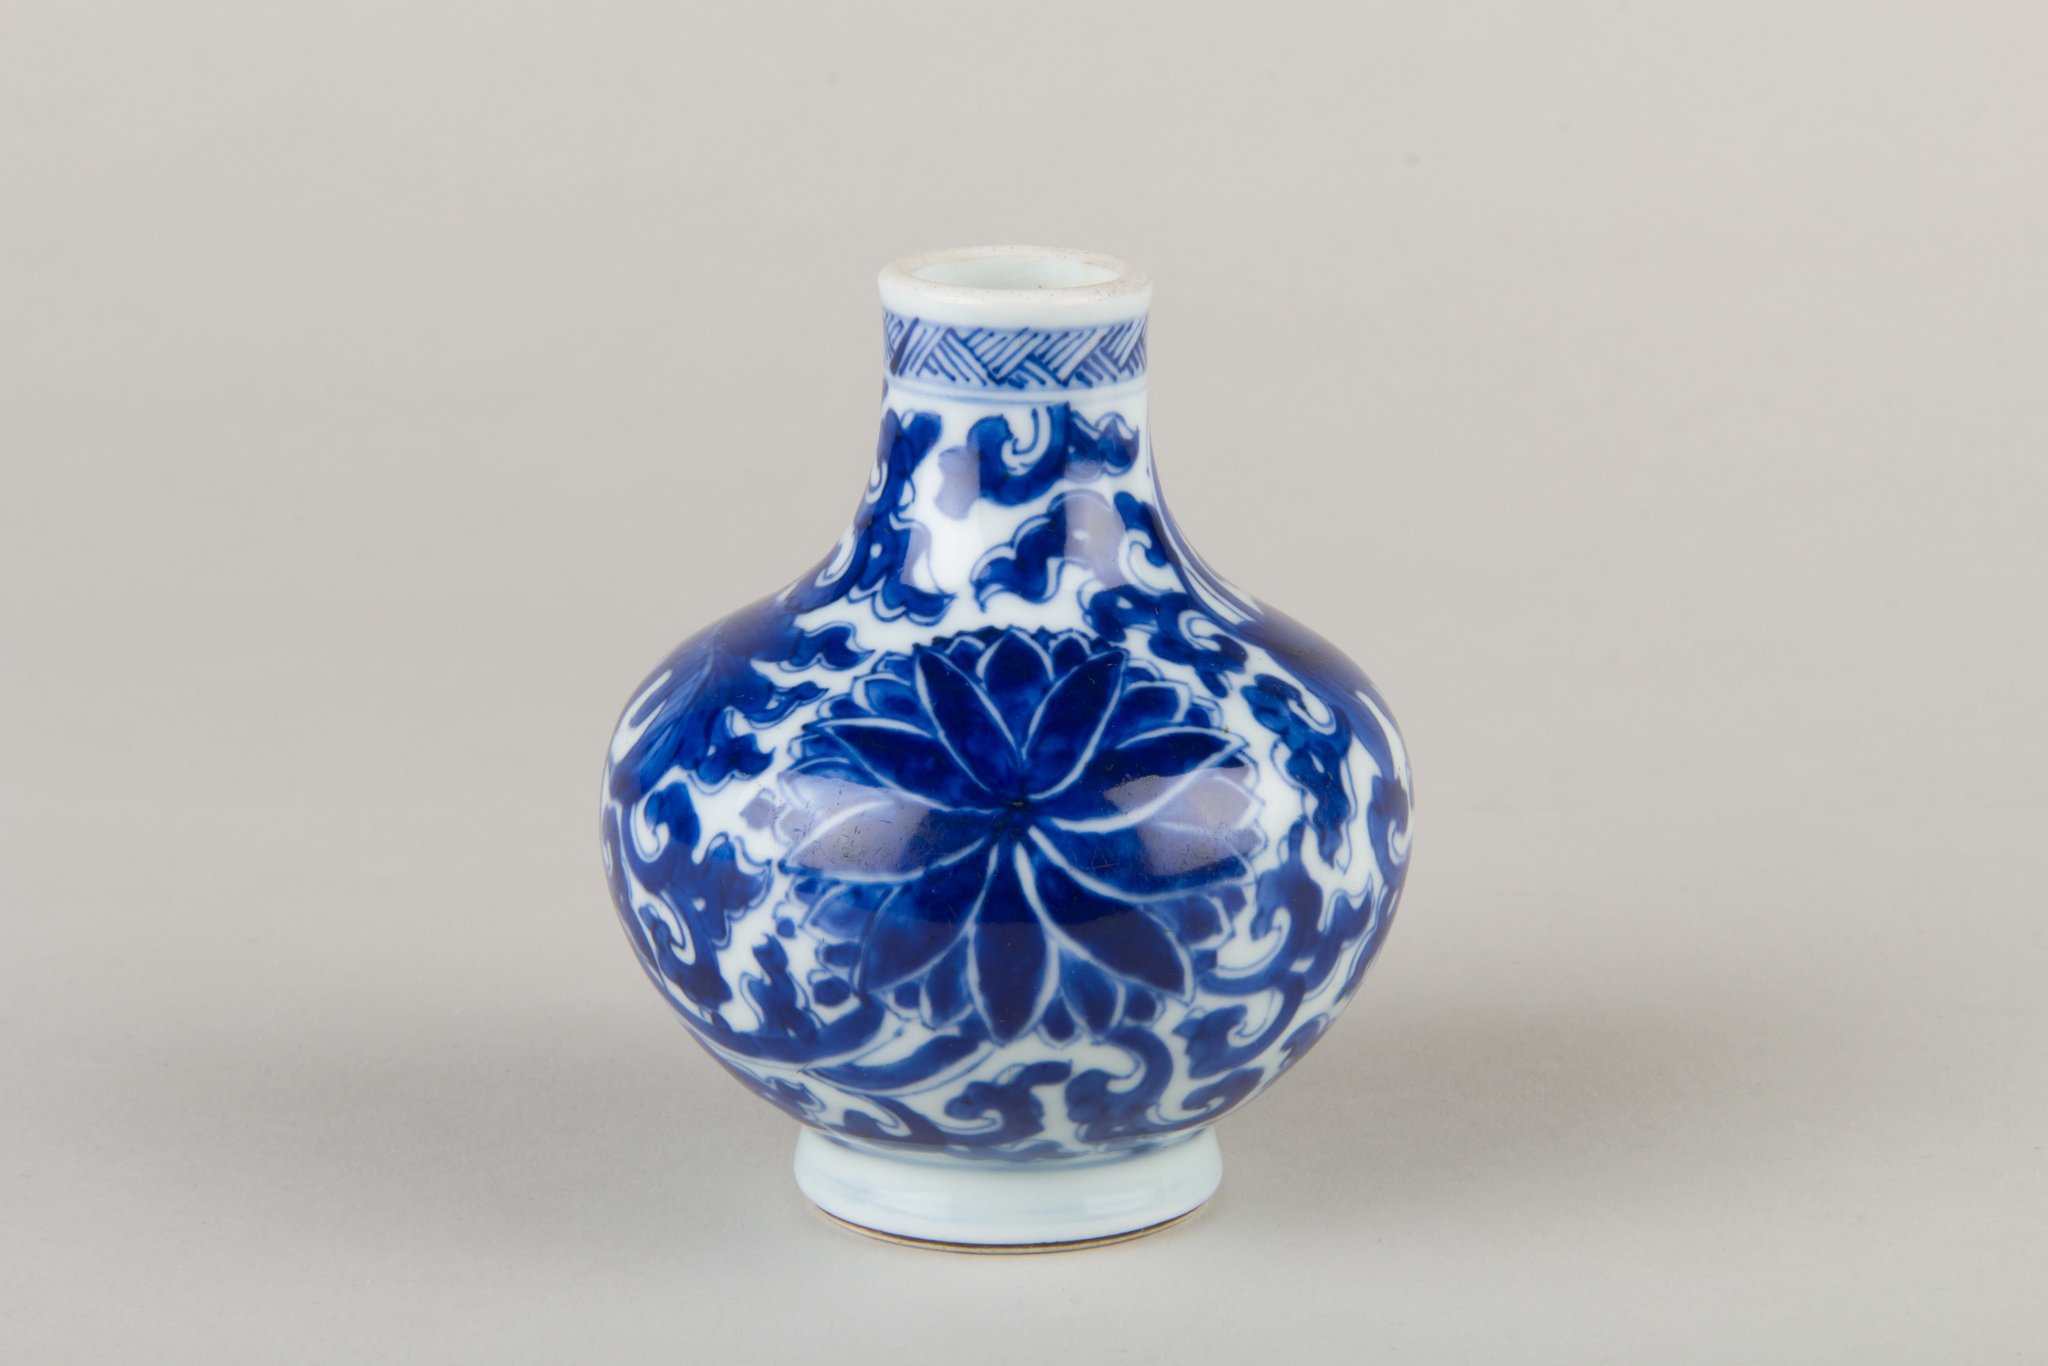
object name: bottle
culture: chinese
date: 1736-1795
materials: porcelain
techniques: underglaze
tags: flowers